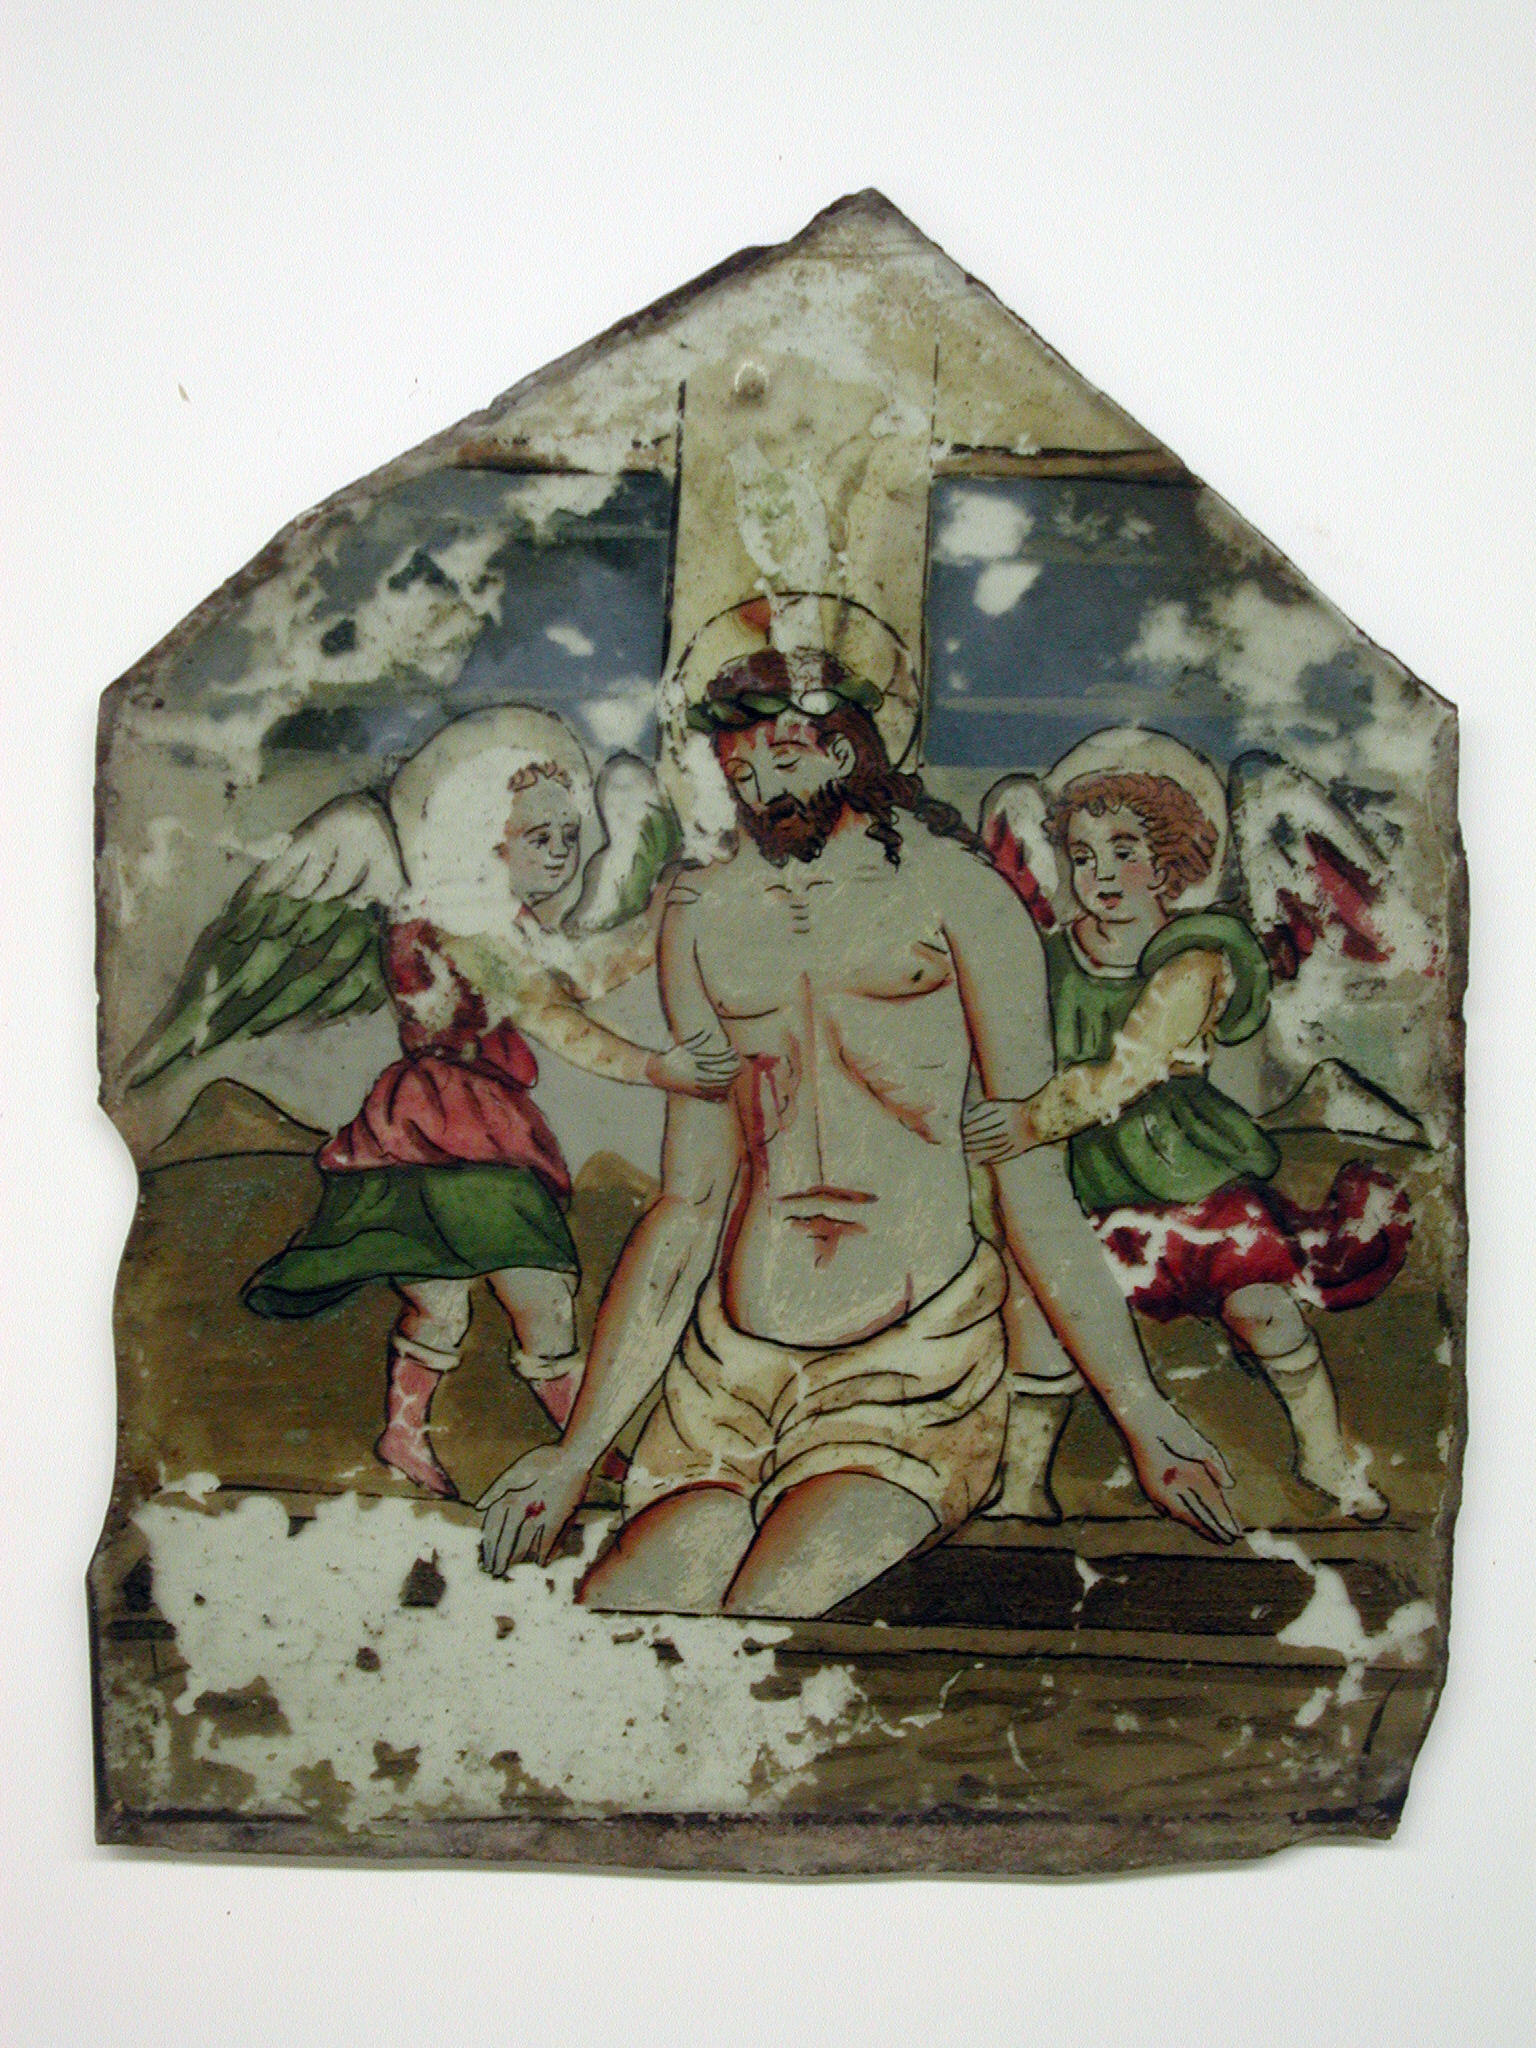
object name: panel or plaque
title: The Dead Christ in the Tomb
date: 1501-1600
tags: angels,christ,death